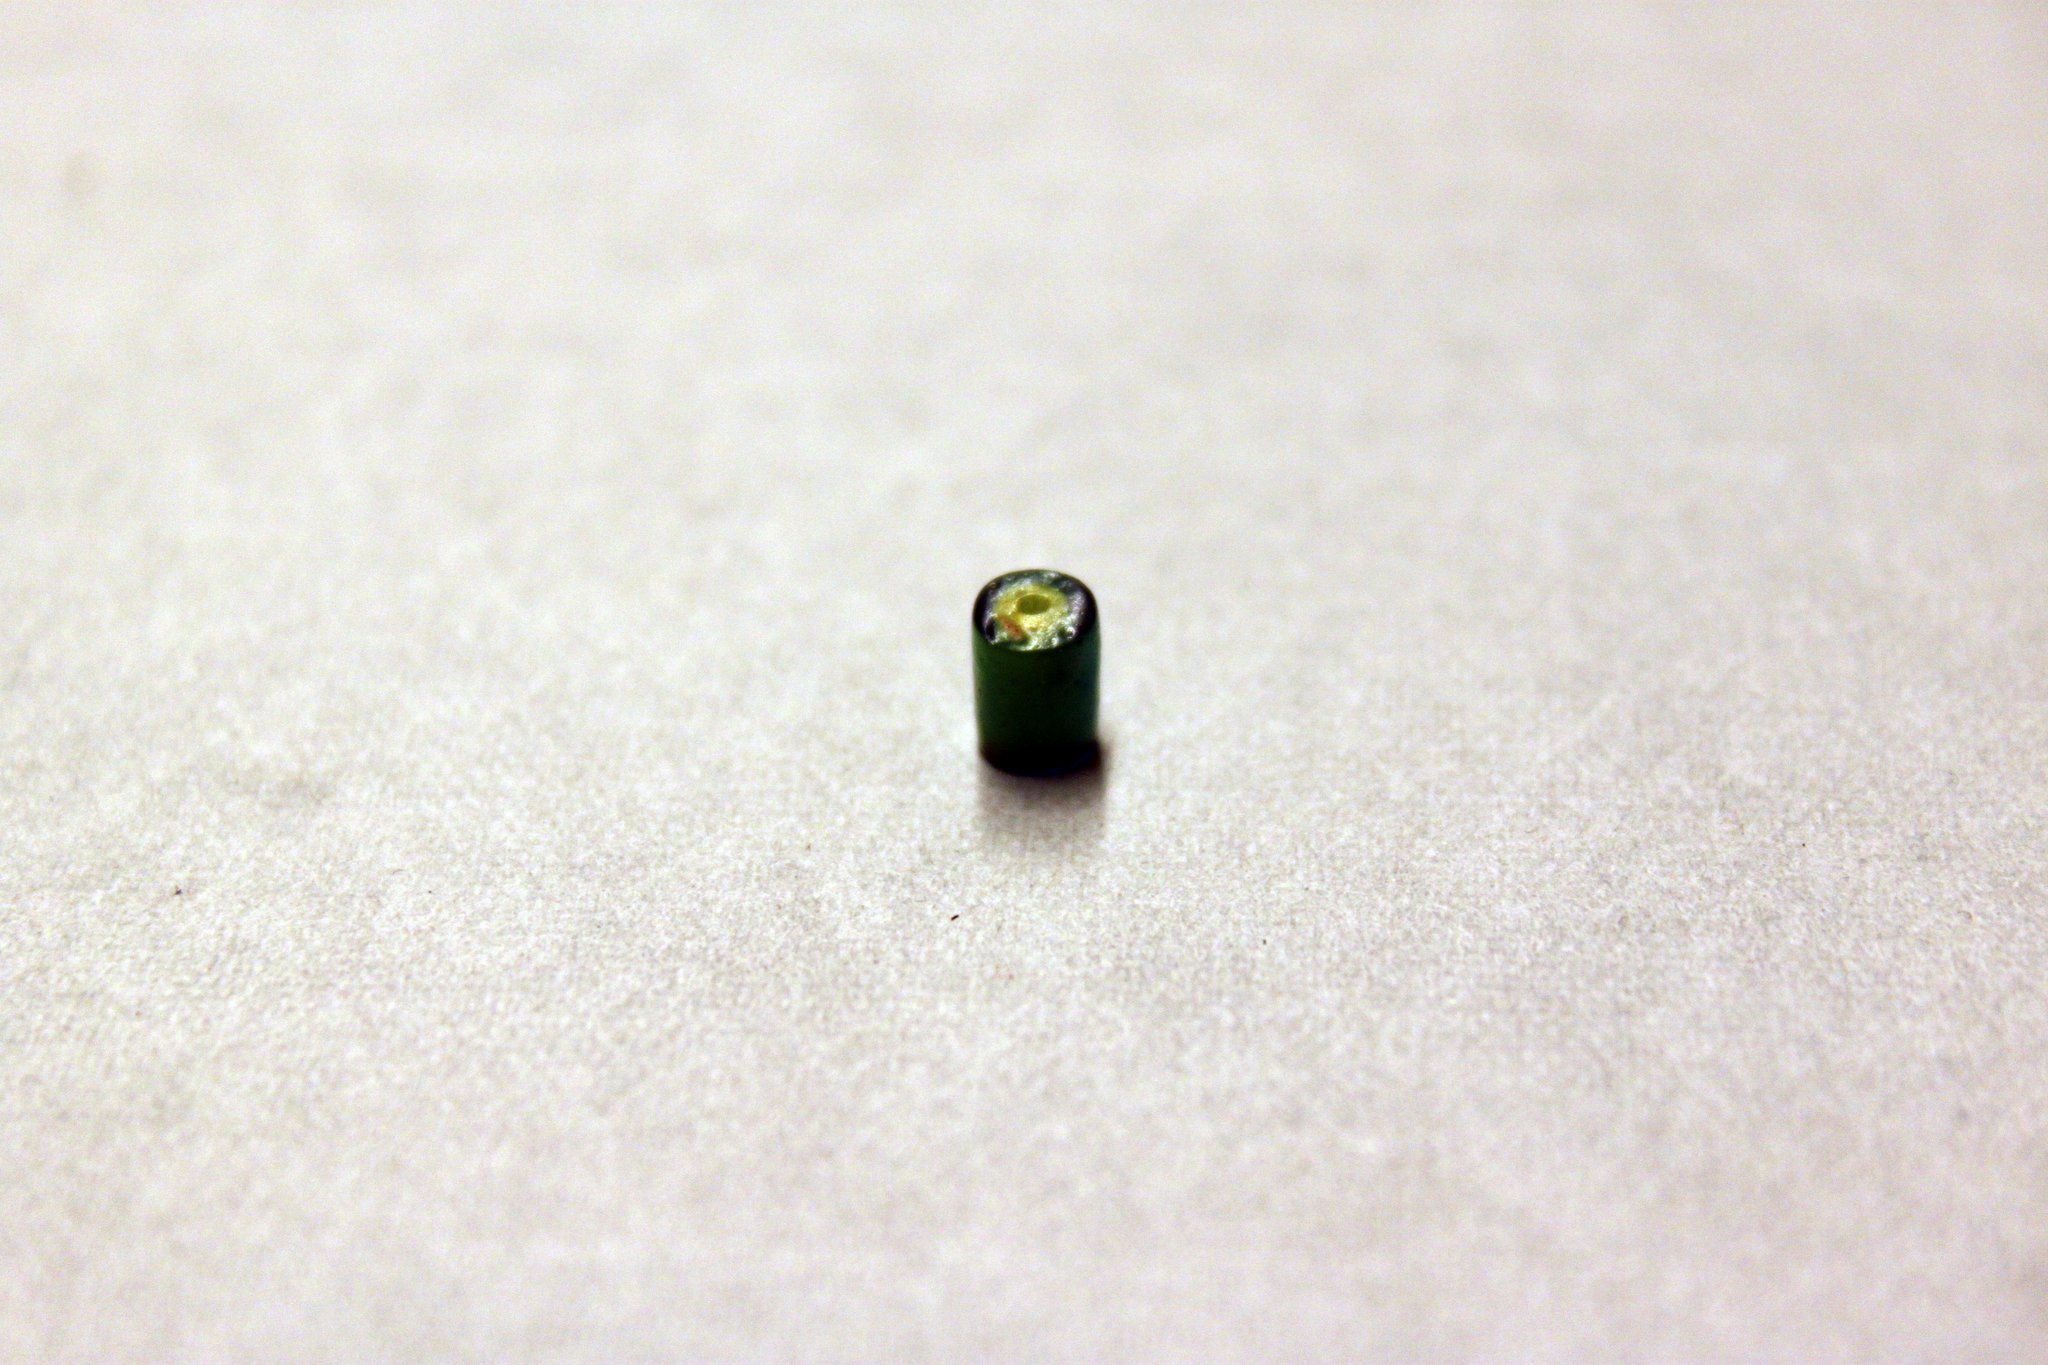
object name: bead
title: Beads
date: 701-1300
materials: glass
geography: iran